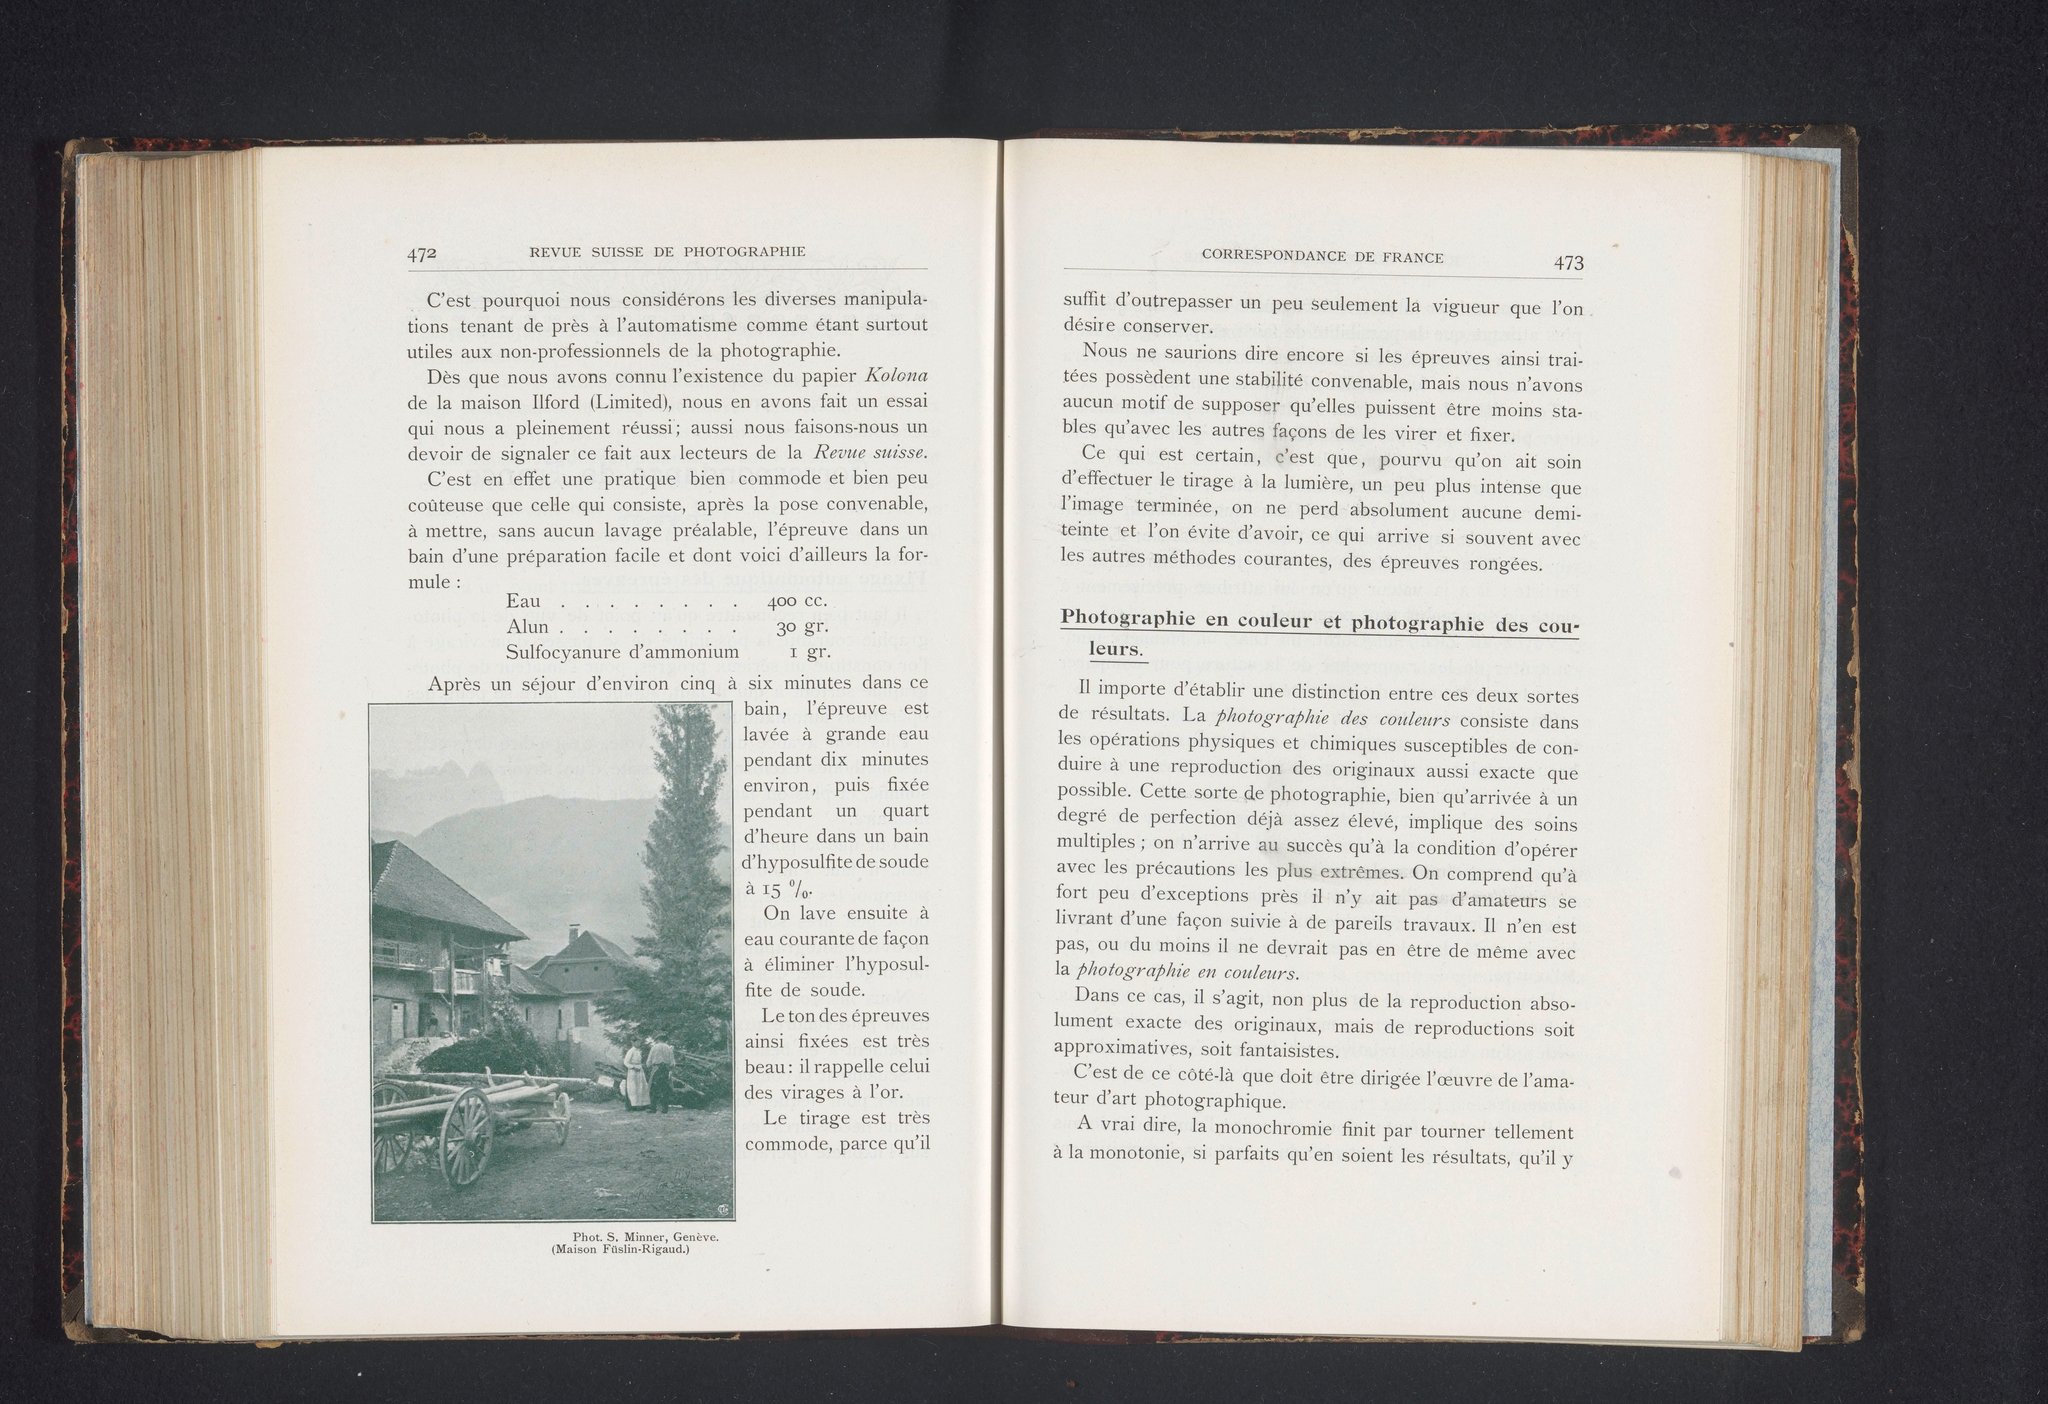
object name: page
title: Gezicht op huizen in de bergen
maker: s. minner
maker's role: fotograaf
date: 1897-1902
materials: paper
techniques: autotype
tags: rural housing, e.g. country-house, villa, cottage, mountains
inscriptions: inscription: ‘Maison Füslin-Rigaud’, monogram: ‘C. Cie’